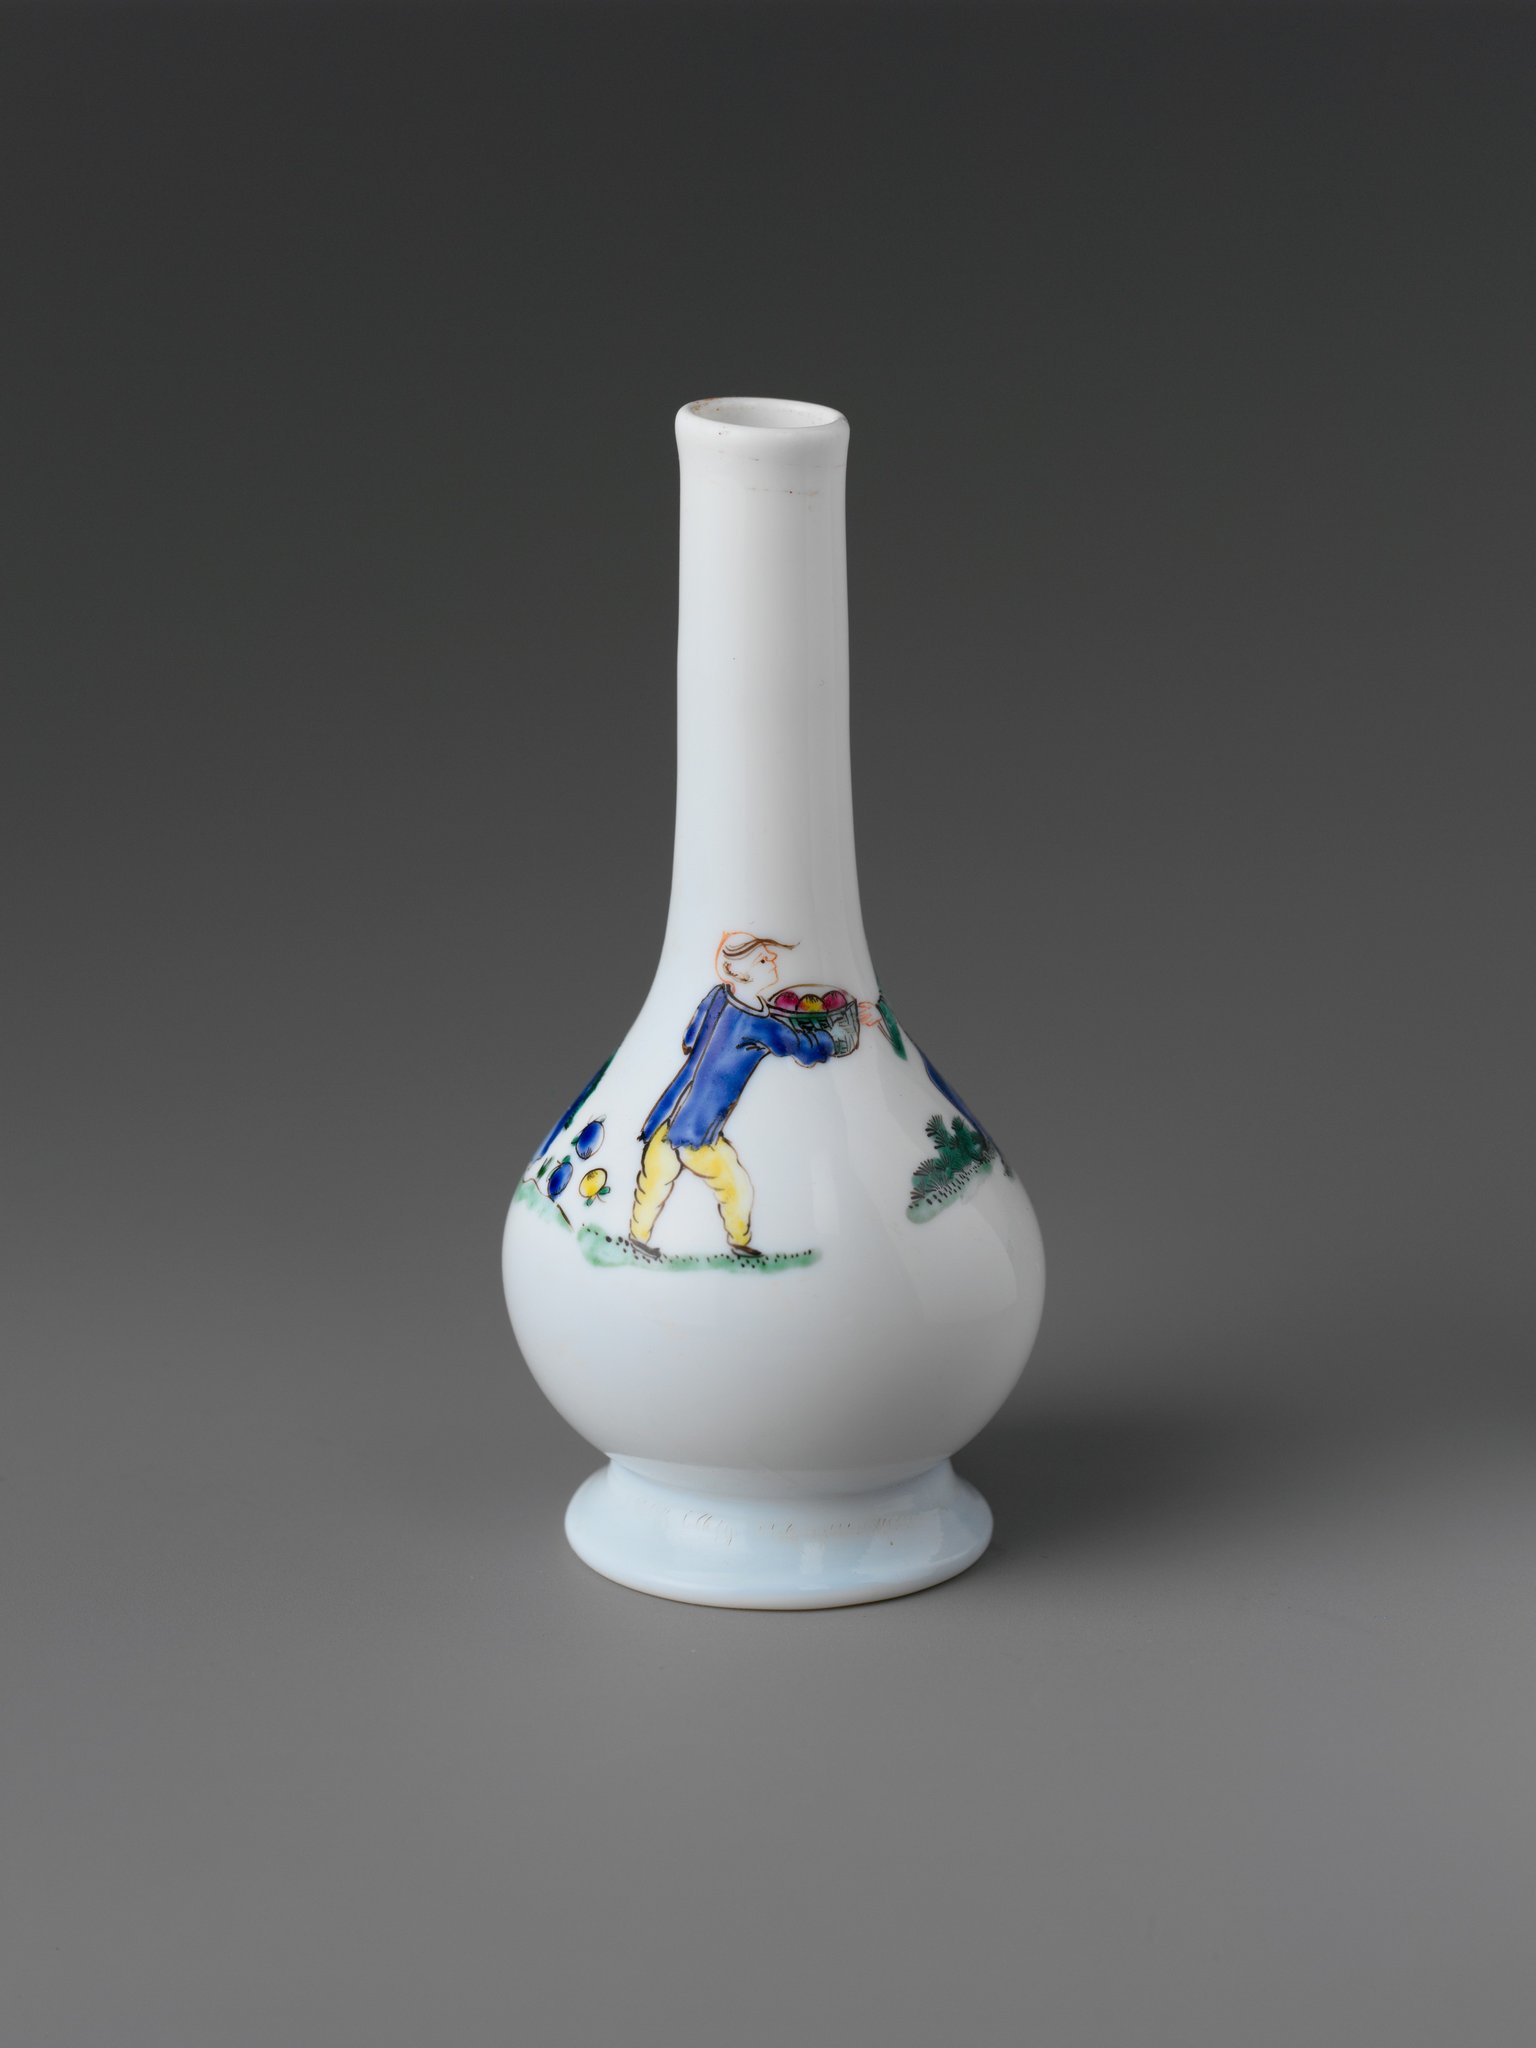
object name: bottle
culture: british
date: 1760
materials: enamel, glass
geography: england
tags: men